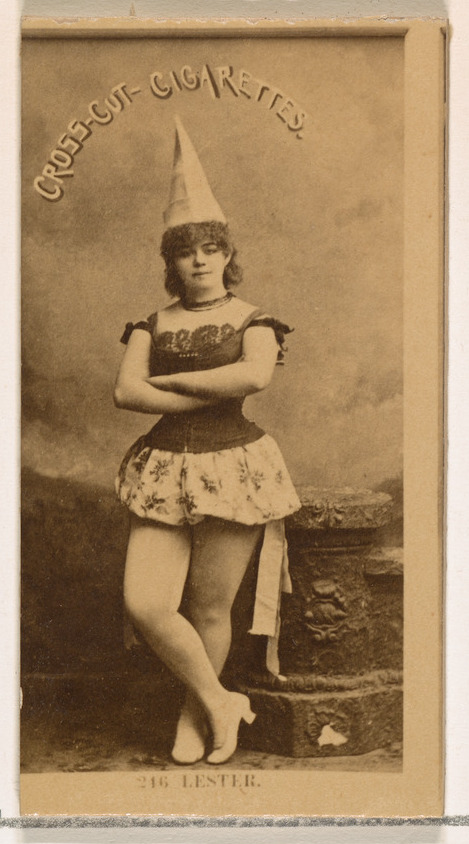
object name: print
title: Card Number 246, Lester, from the Actors and Actresses series (N145-2) issued by Duke Sons & Co. to promote Cross Cut Cigarettes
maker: w. duke, sons & co.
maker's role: publisher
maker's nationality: american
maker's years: 1870-1920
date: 1880-1889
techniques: albumen silver print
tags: portraits,women,actresses